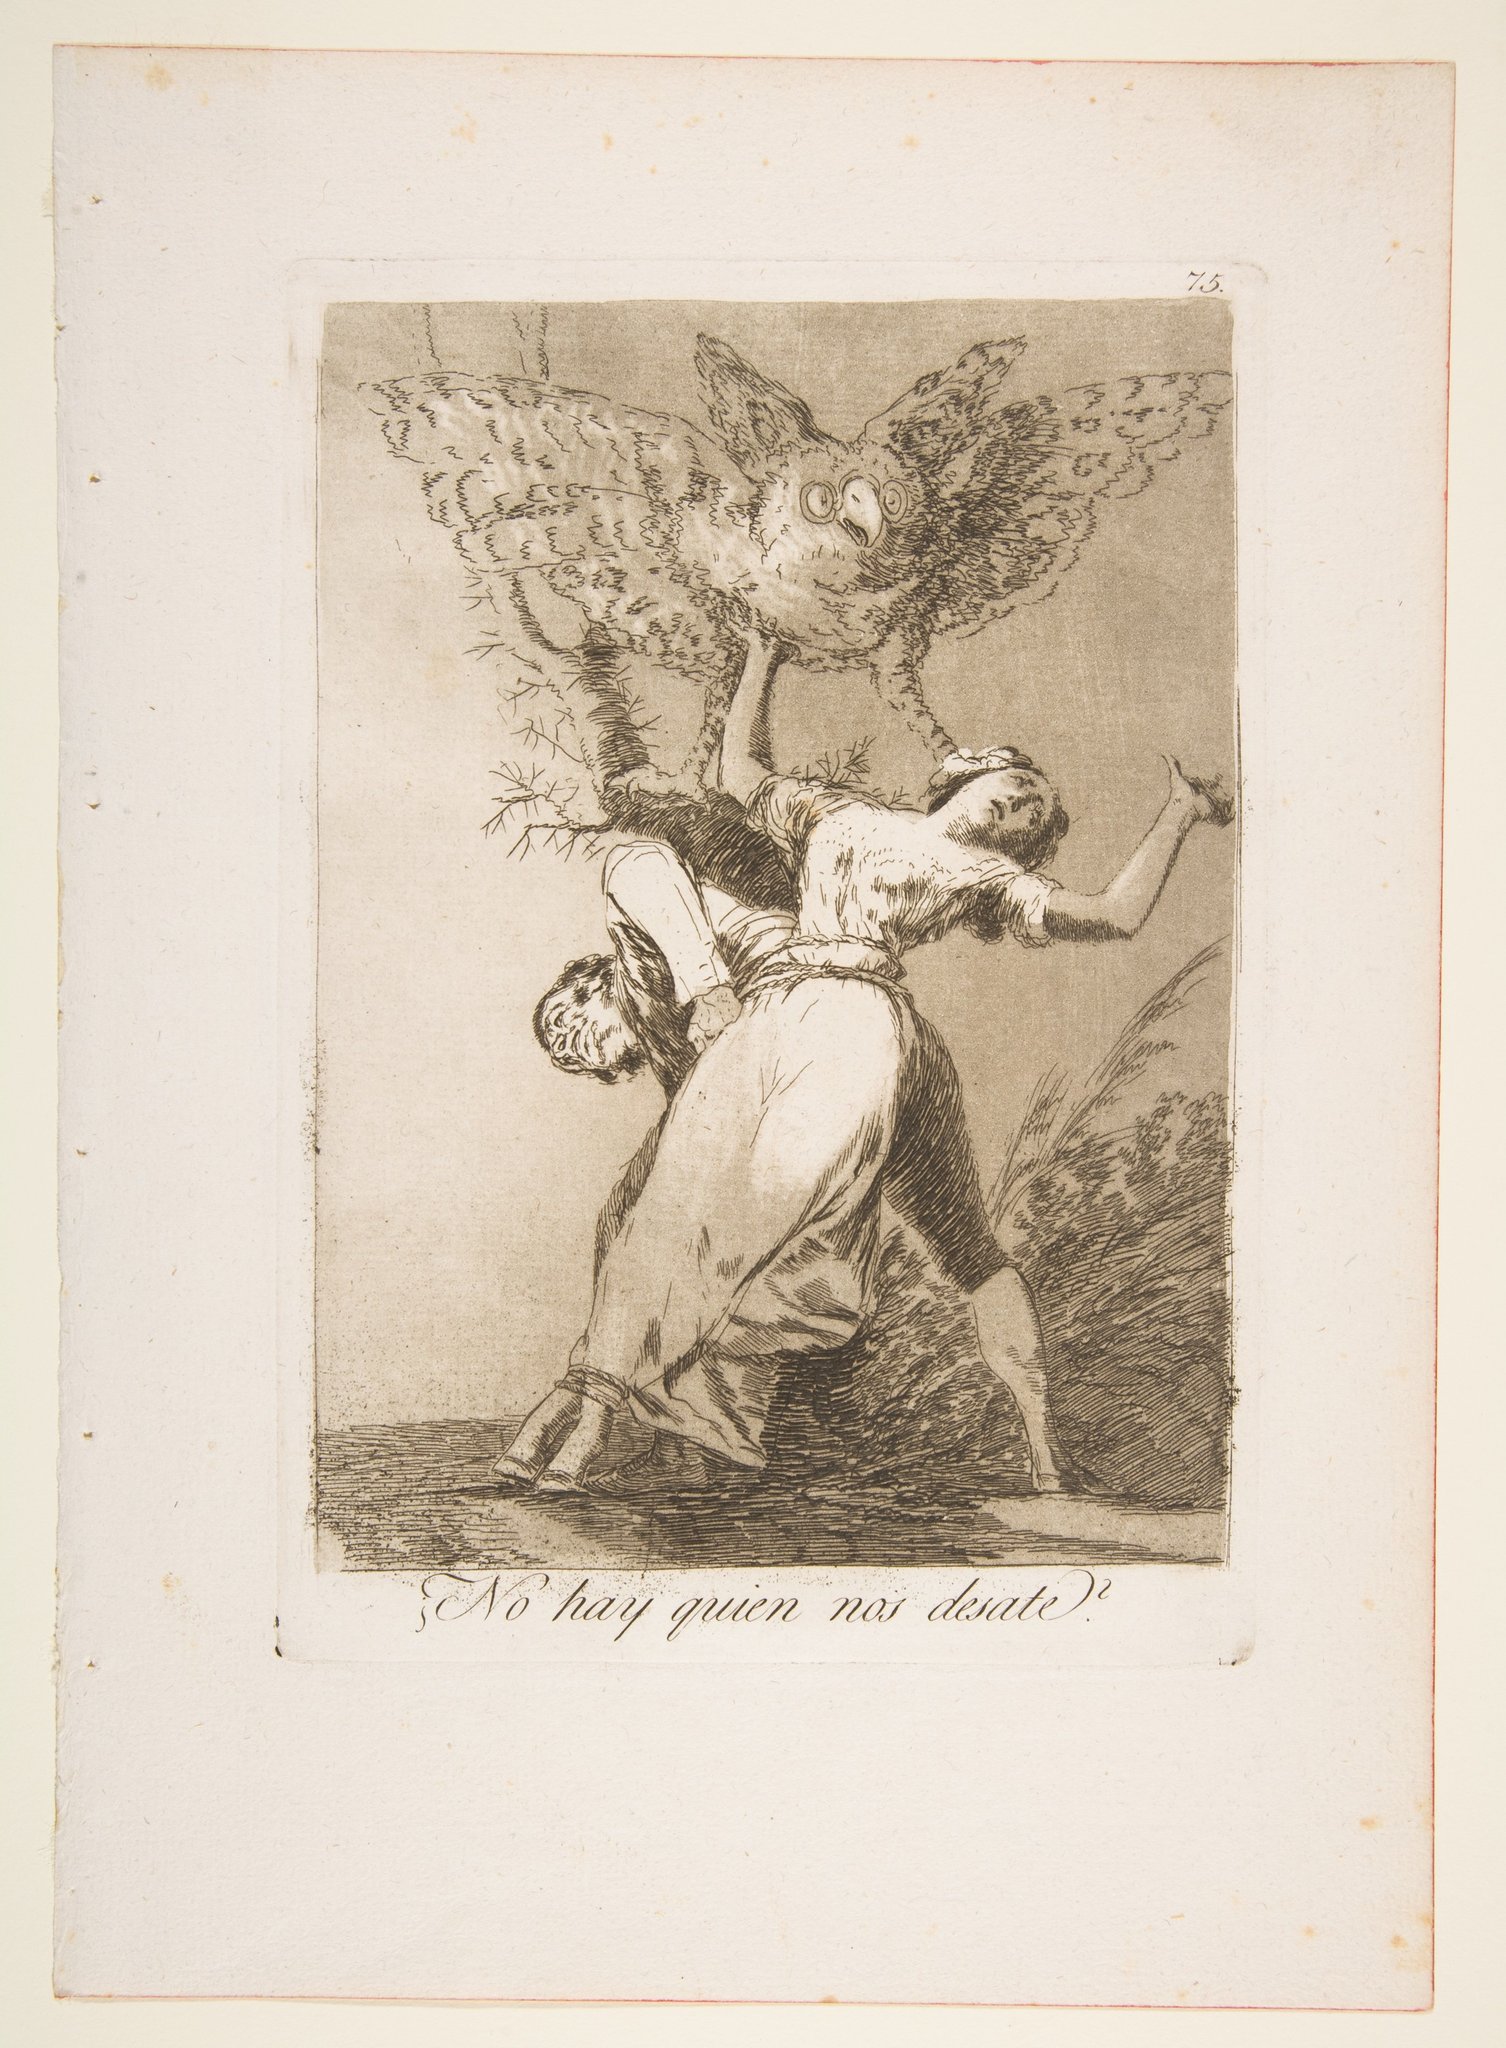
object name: print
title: Plate 75 from "Los Caprichos": Is there no one to untie us? (¿No hay quien nos desate?)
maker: goya (francisco de goya y lucientes)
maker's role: artist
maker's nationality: spanish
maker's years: 1746-1828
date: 1799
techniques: aquatint, burnishing, etching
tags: men,women,owls